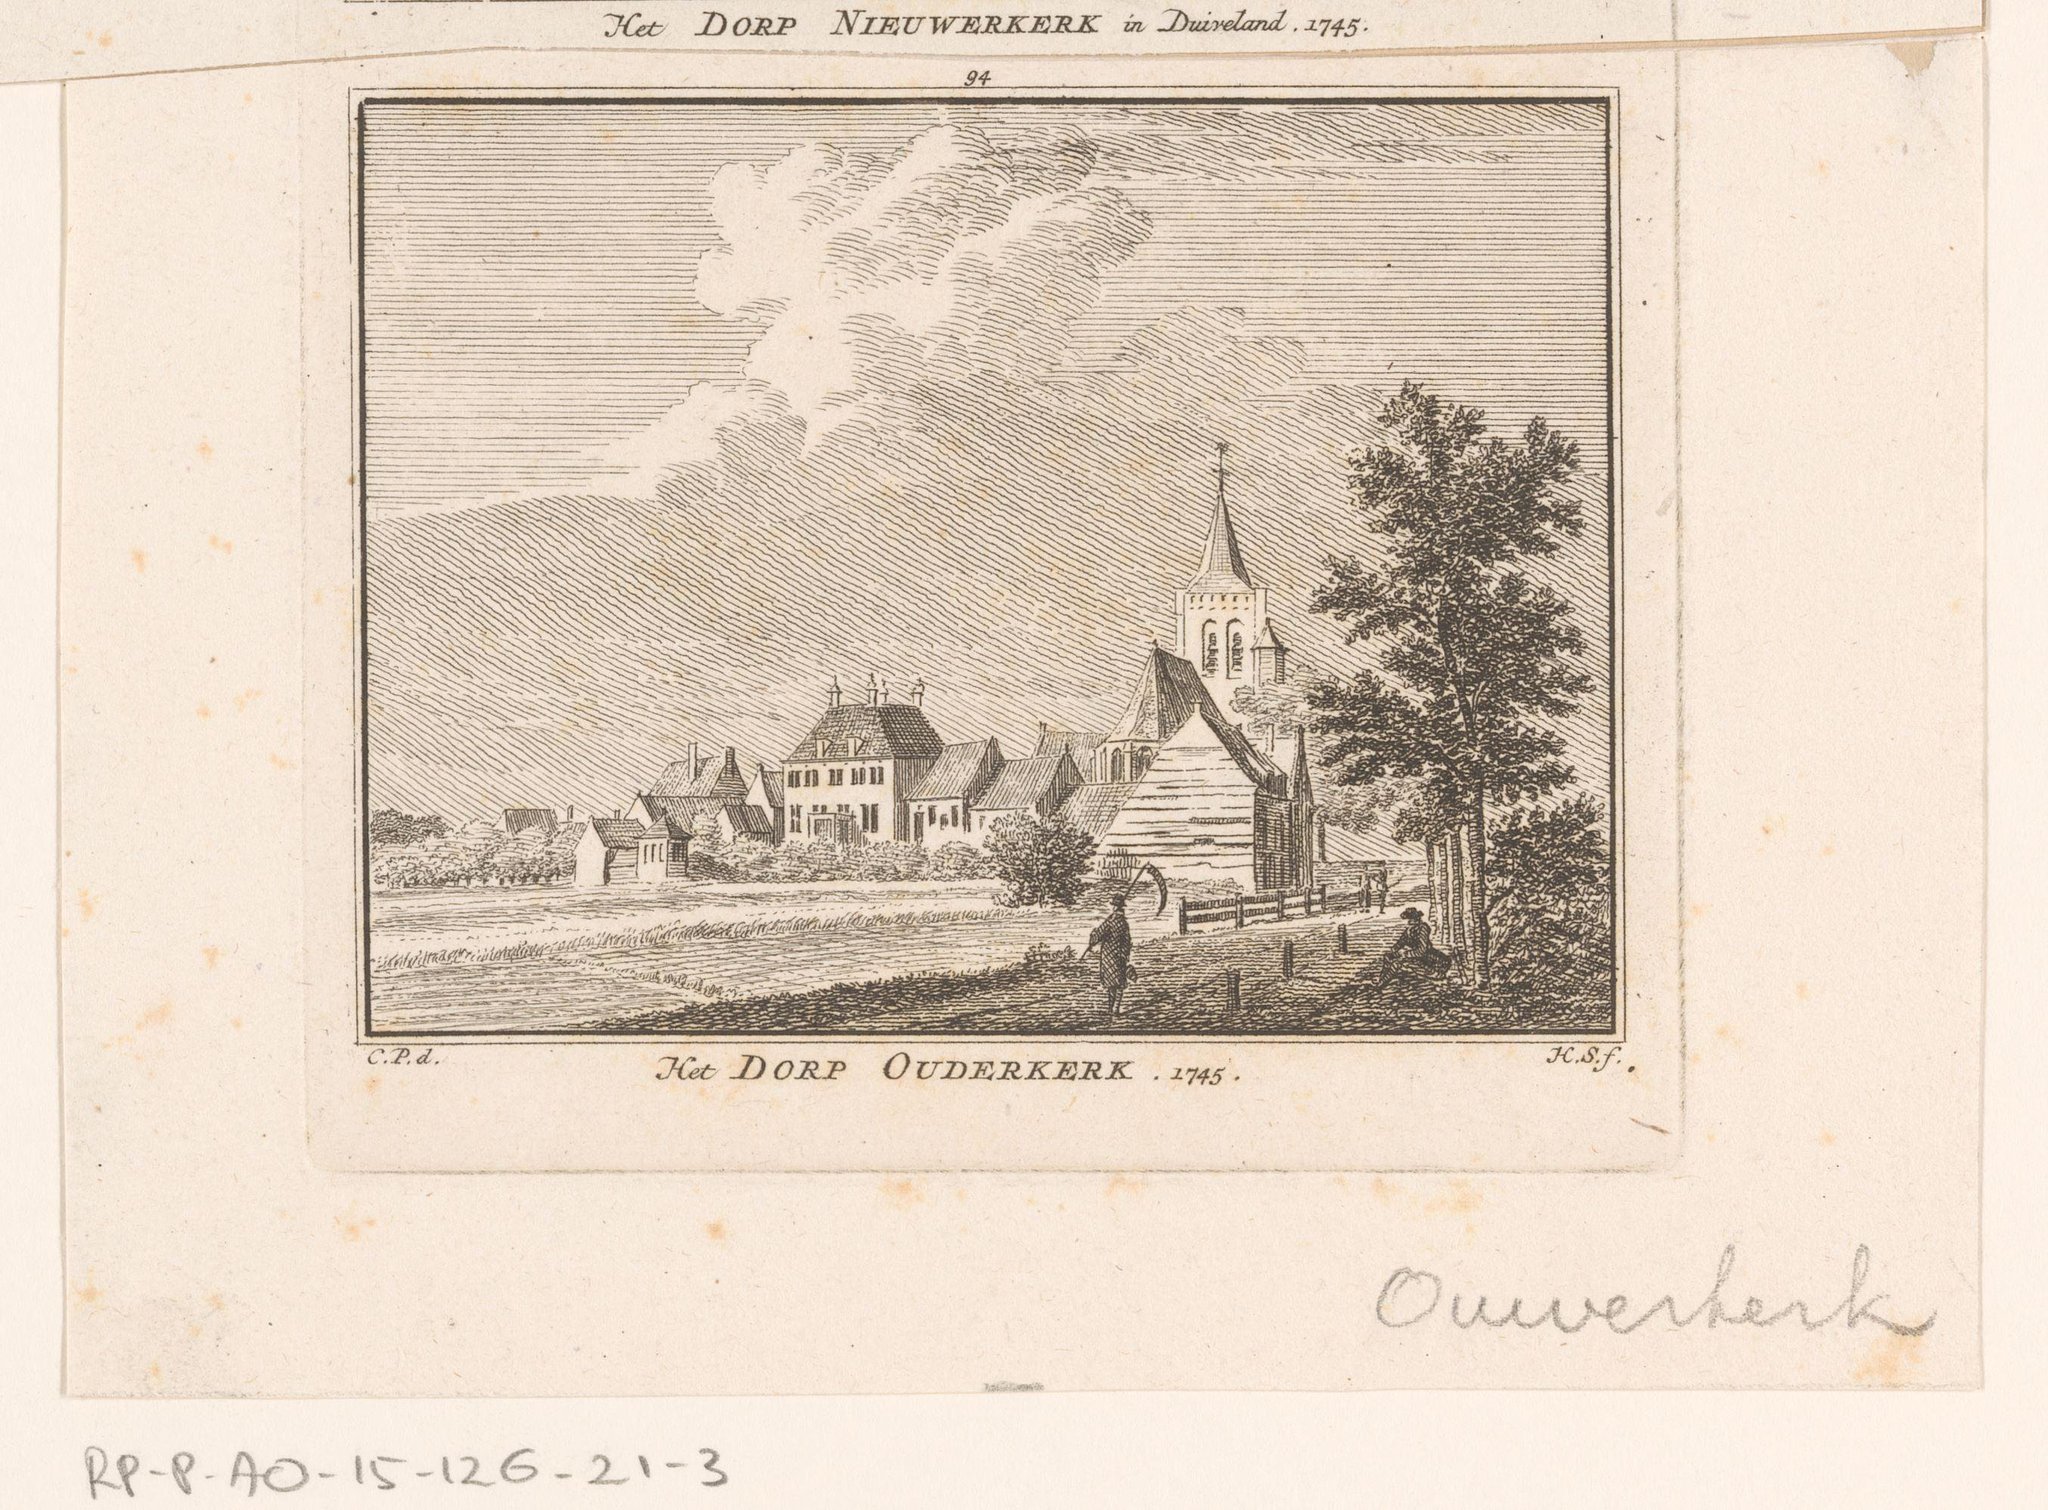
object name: book illustration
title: Gezicht op een straat in Nieuwerkerk, 1745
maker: hendrik spilman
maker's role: draughtsman, painter, print maker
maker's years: 1721-1784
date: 1754-1792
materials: paper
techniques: etching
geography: haarlem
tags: church (exterior), village street (+ city(-scape) with figures, staffage)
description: Prent ook gebruikt in: Het verheerlykt Nederland of kabinet van hedendaagsche gezigten van steden, dorpen (…). 9 delen. Amsterdam: Isaak Tirion en weduwe Isaak Tirion, 1745-1774, dl. 5 (1754), ill. 93. Of in: Nederlandsche tafereelen; of eene keurige verzameling van negen honderd fraaije gezigten van steden, dorpen, sloten, oudheden [….]. 9 delen. Amsterdam: Jan de Groot, 1792, dl. 5, ill. 93.